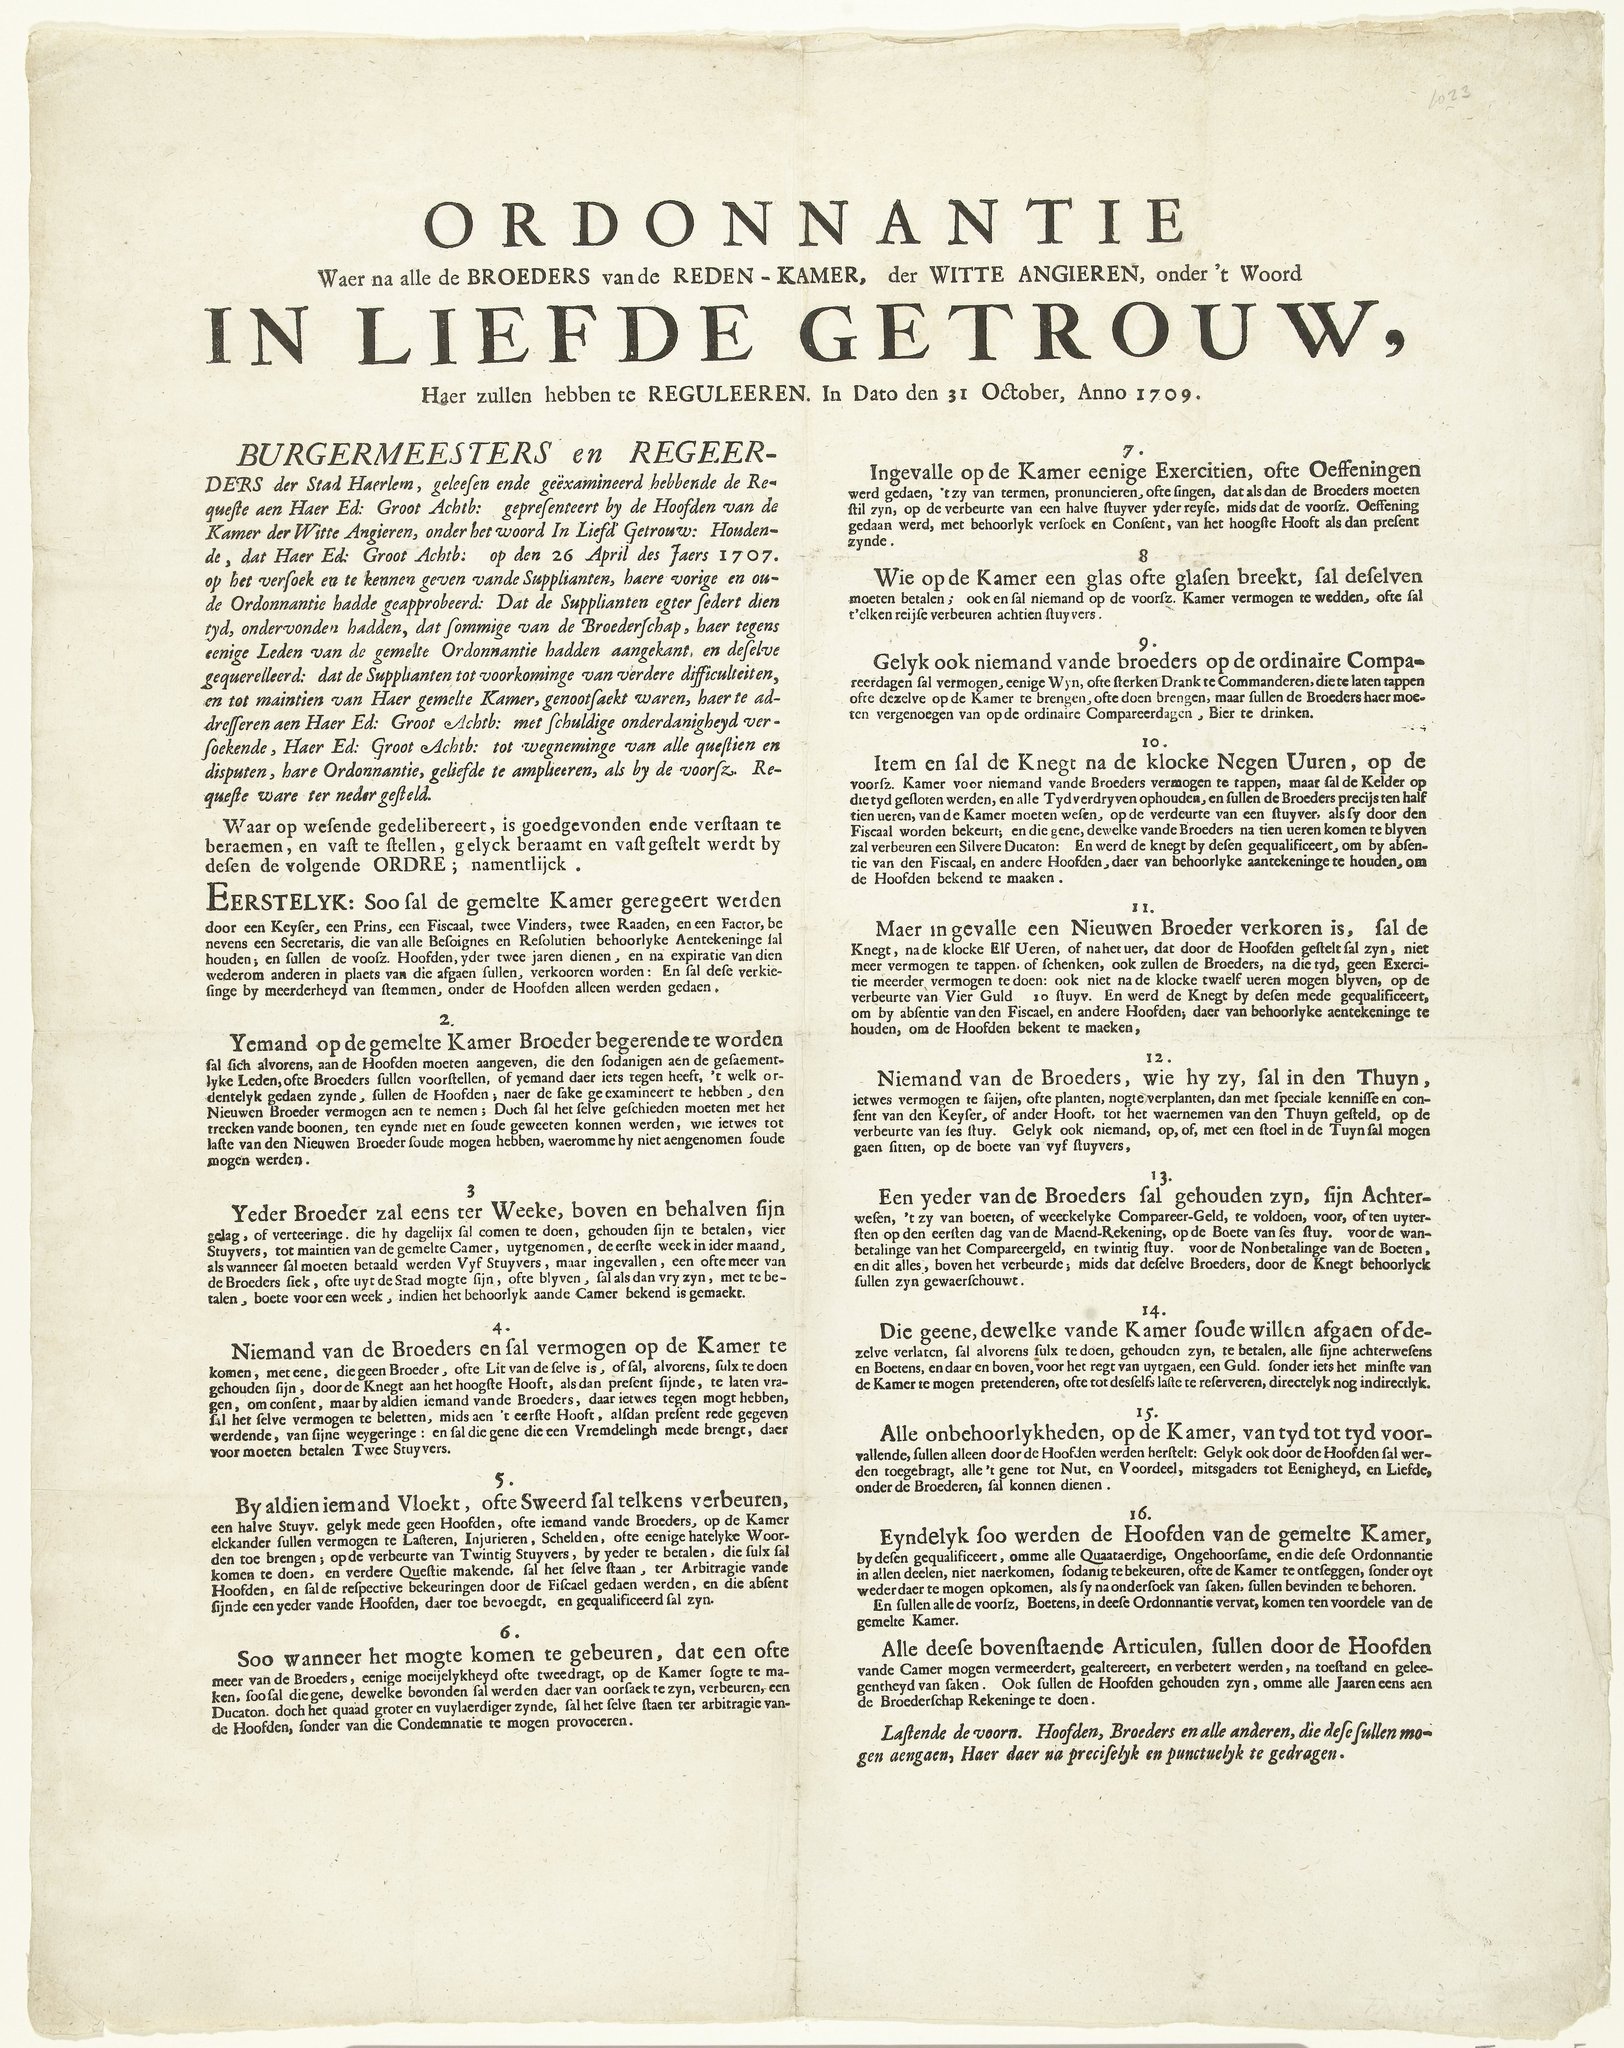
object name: text sheet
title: Reglementen voor de Haarlemse rederijkerskamer De Witte Angieren, 1709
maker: Anonymous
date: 1709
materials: paper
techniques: letterpress printing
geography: haarlem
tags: haarlem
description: Tekstblad et in twee kolommen de 16 reglementen voor de Haarlemse rederijkerskamer De Witte Angieren, 1709. Met de zinspreuk: In Liefde Getrouw.